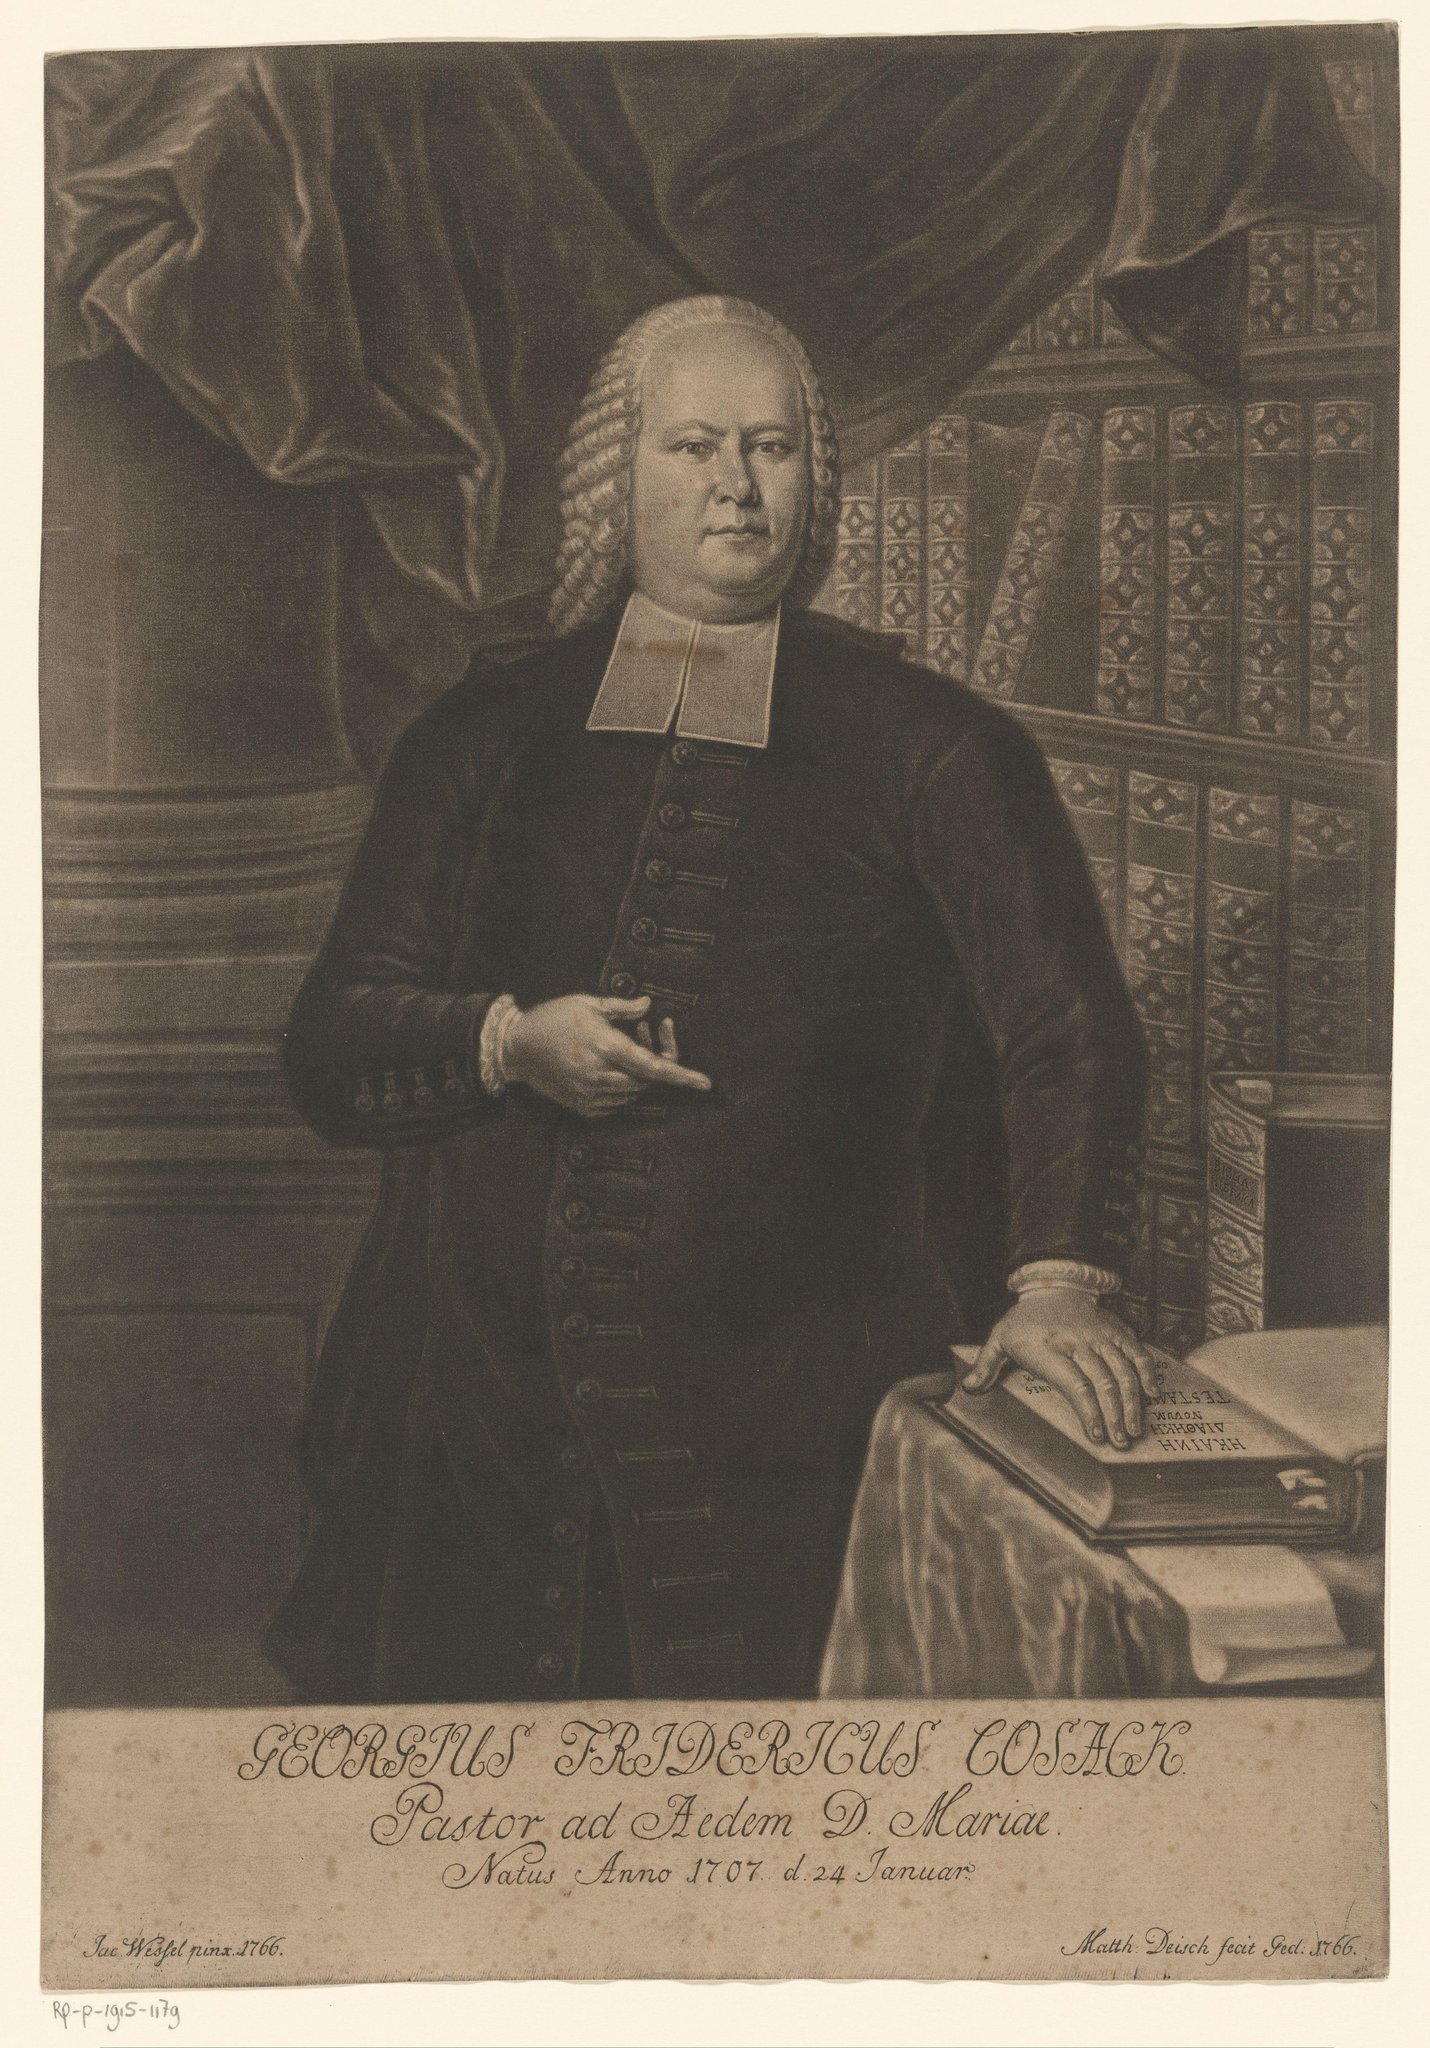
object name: print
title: Portret van Georgius Fridericus Cosack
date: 1766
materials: paper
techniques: mezzotint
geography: gdansk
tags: bookshelves, historical persons, book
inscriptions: collector's mark: Lugt 2228